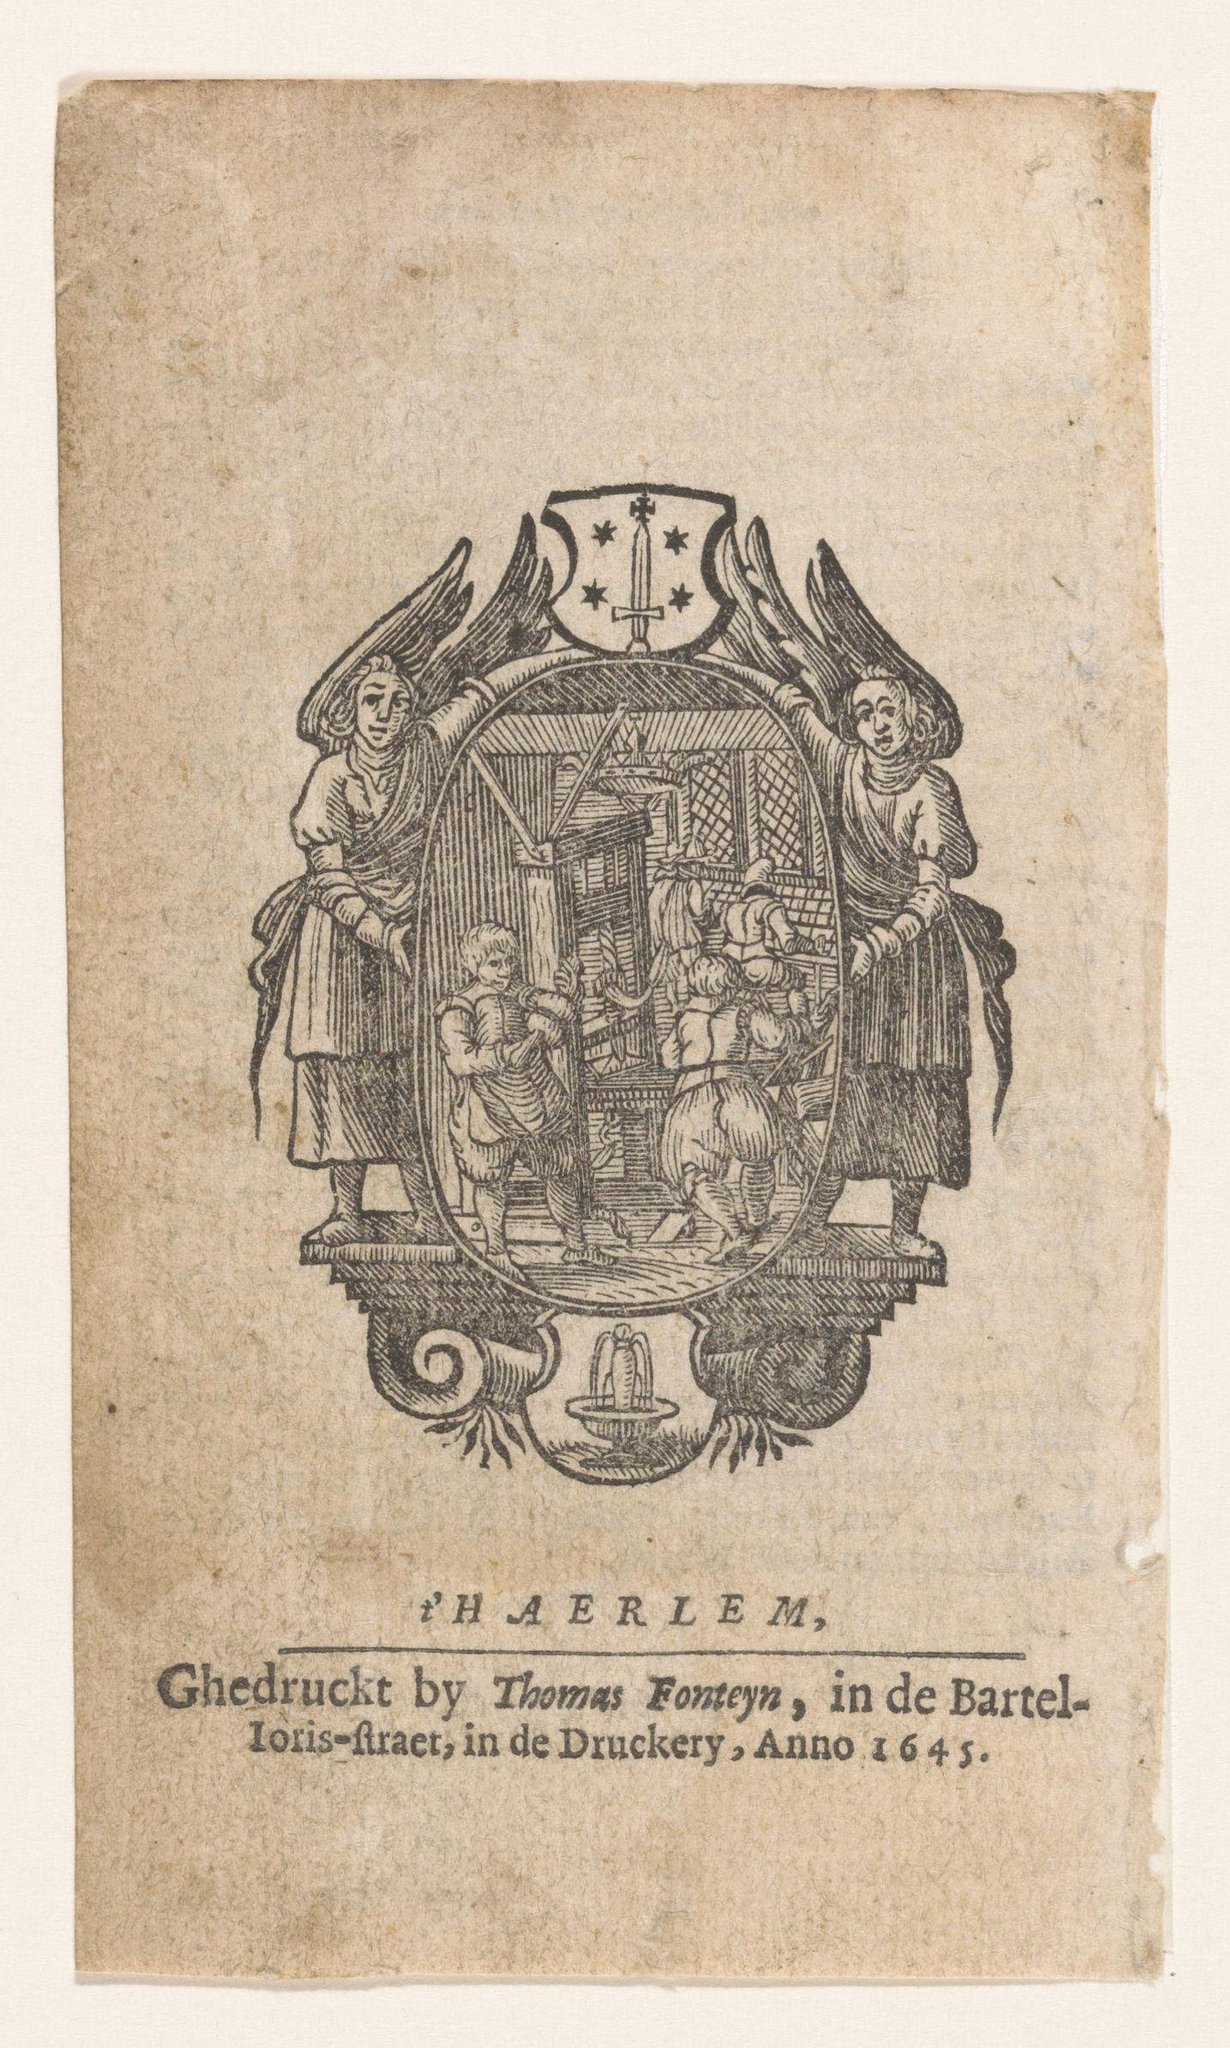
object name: book illustration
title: Drukkersmerk van Thomas Fonteyn te Haarlem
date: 1645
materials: paper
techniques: letterpress printing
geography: amsterdam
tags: printing press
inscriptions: collector's mark: Lugt 2228, collector's mark: Lugt 4779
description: Interieur van een boekdrukkerij met een man die een drukpers bedient en een man die twee inkttampons over elkaar wrijft. Voor het raam zit een man voor een letterkast. In een omlijsting bestaande uit twee engelen, een fontein en het wapen van Haarlem.